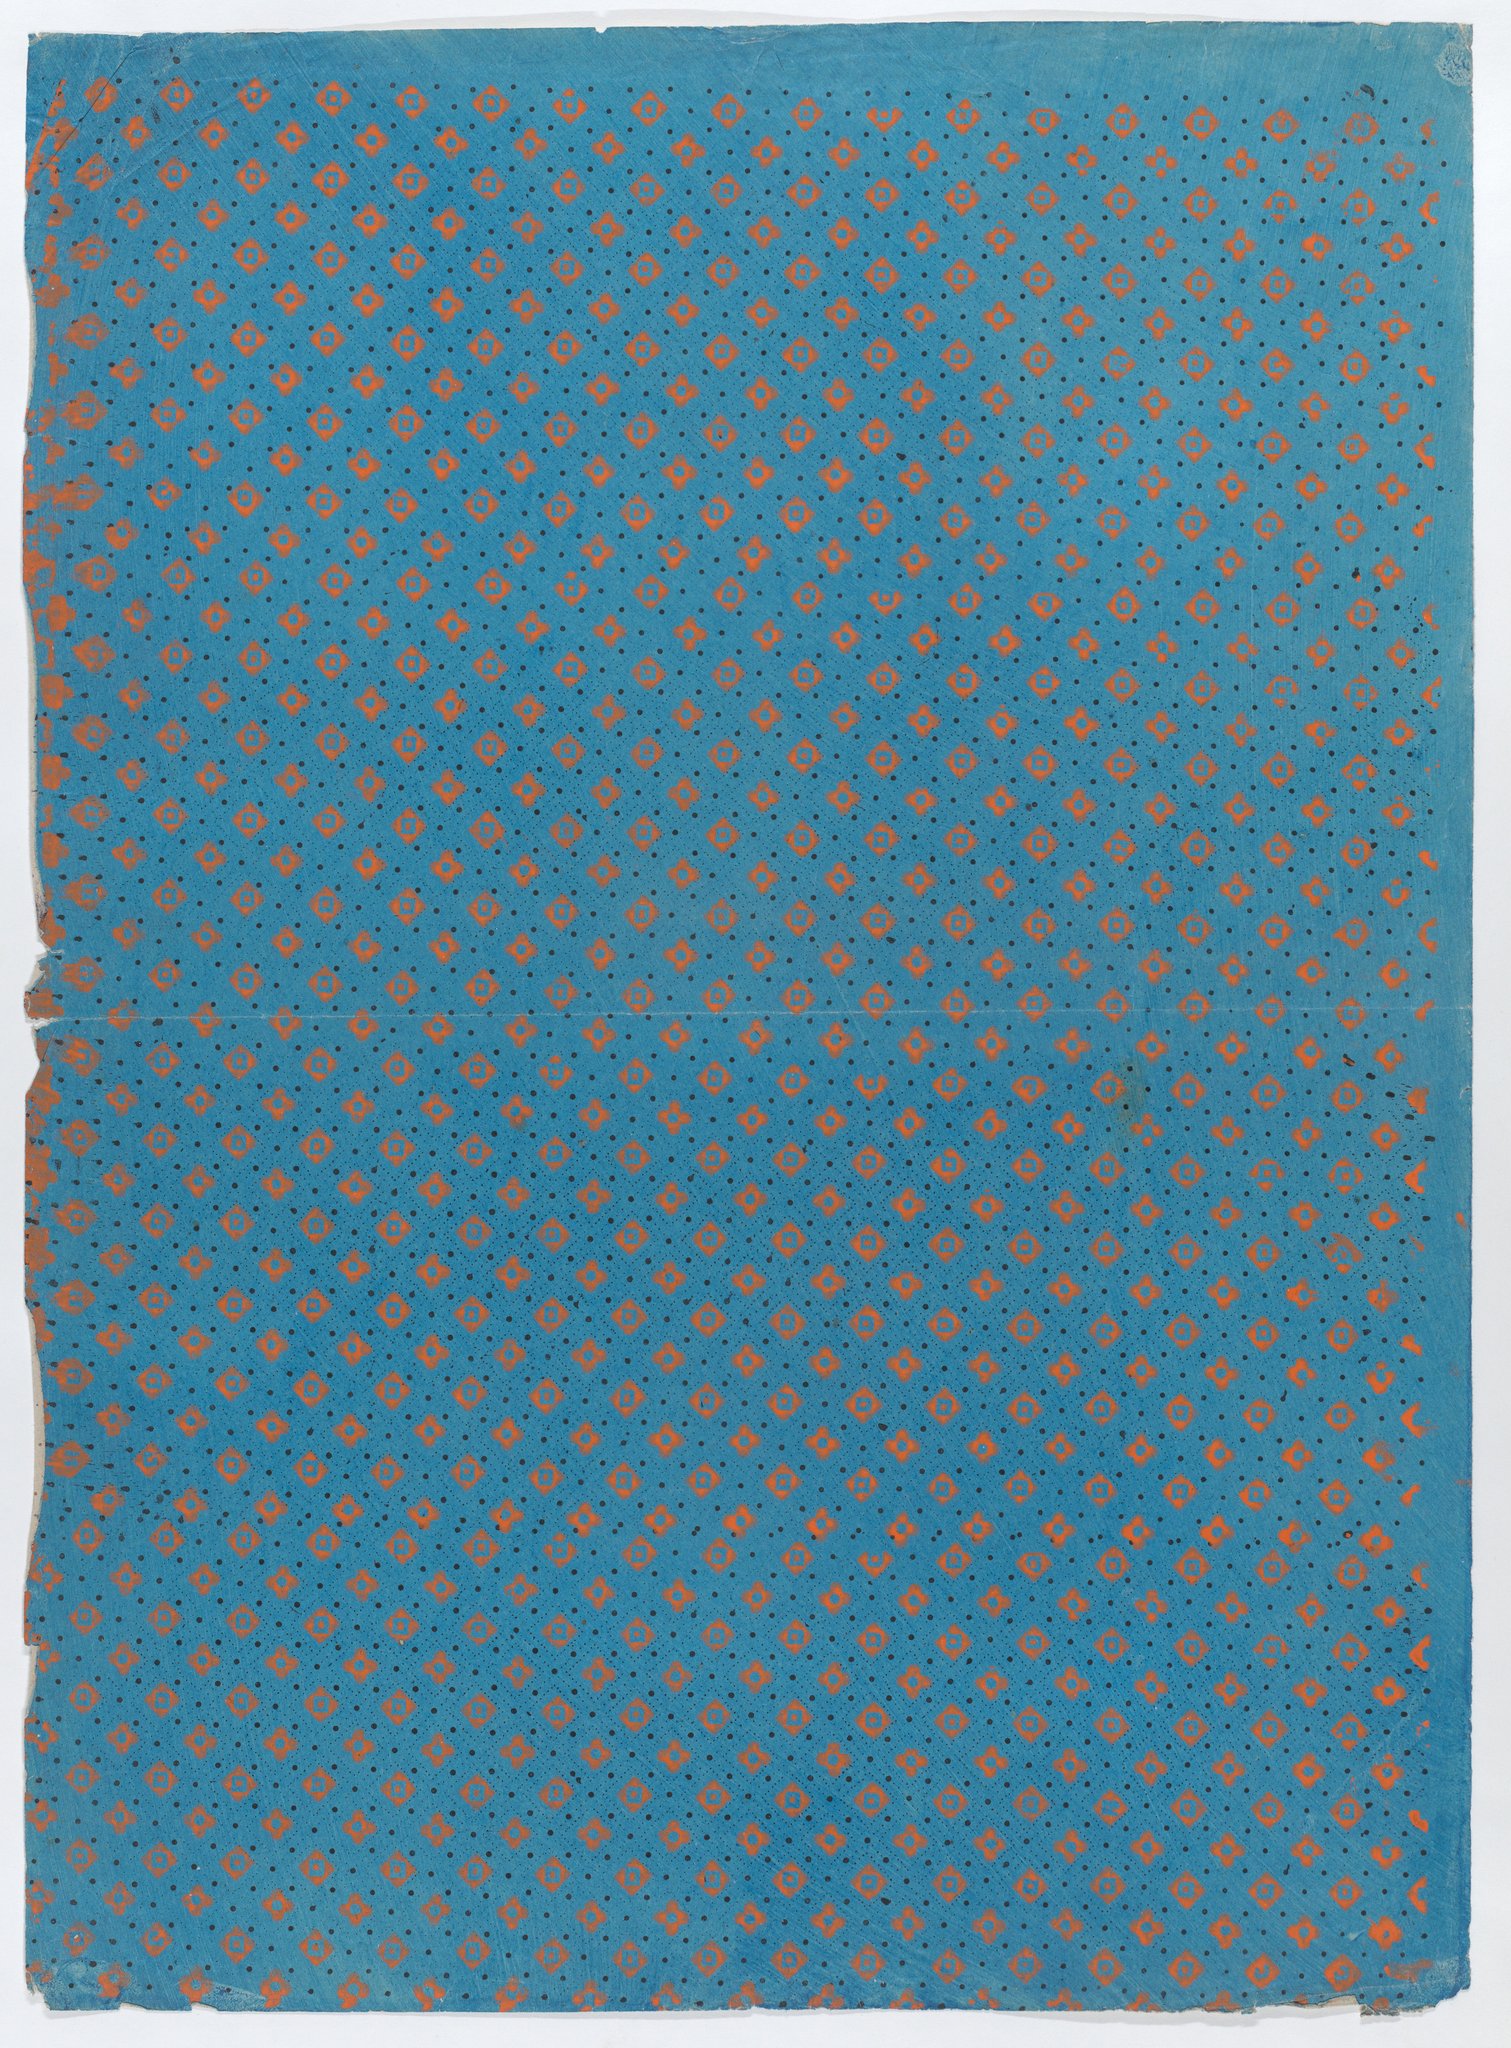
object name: print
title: Sheet with an overall dot and floral pattern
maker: Anonymous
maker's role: artist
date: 1767-1866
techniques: relief print